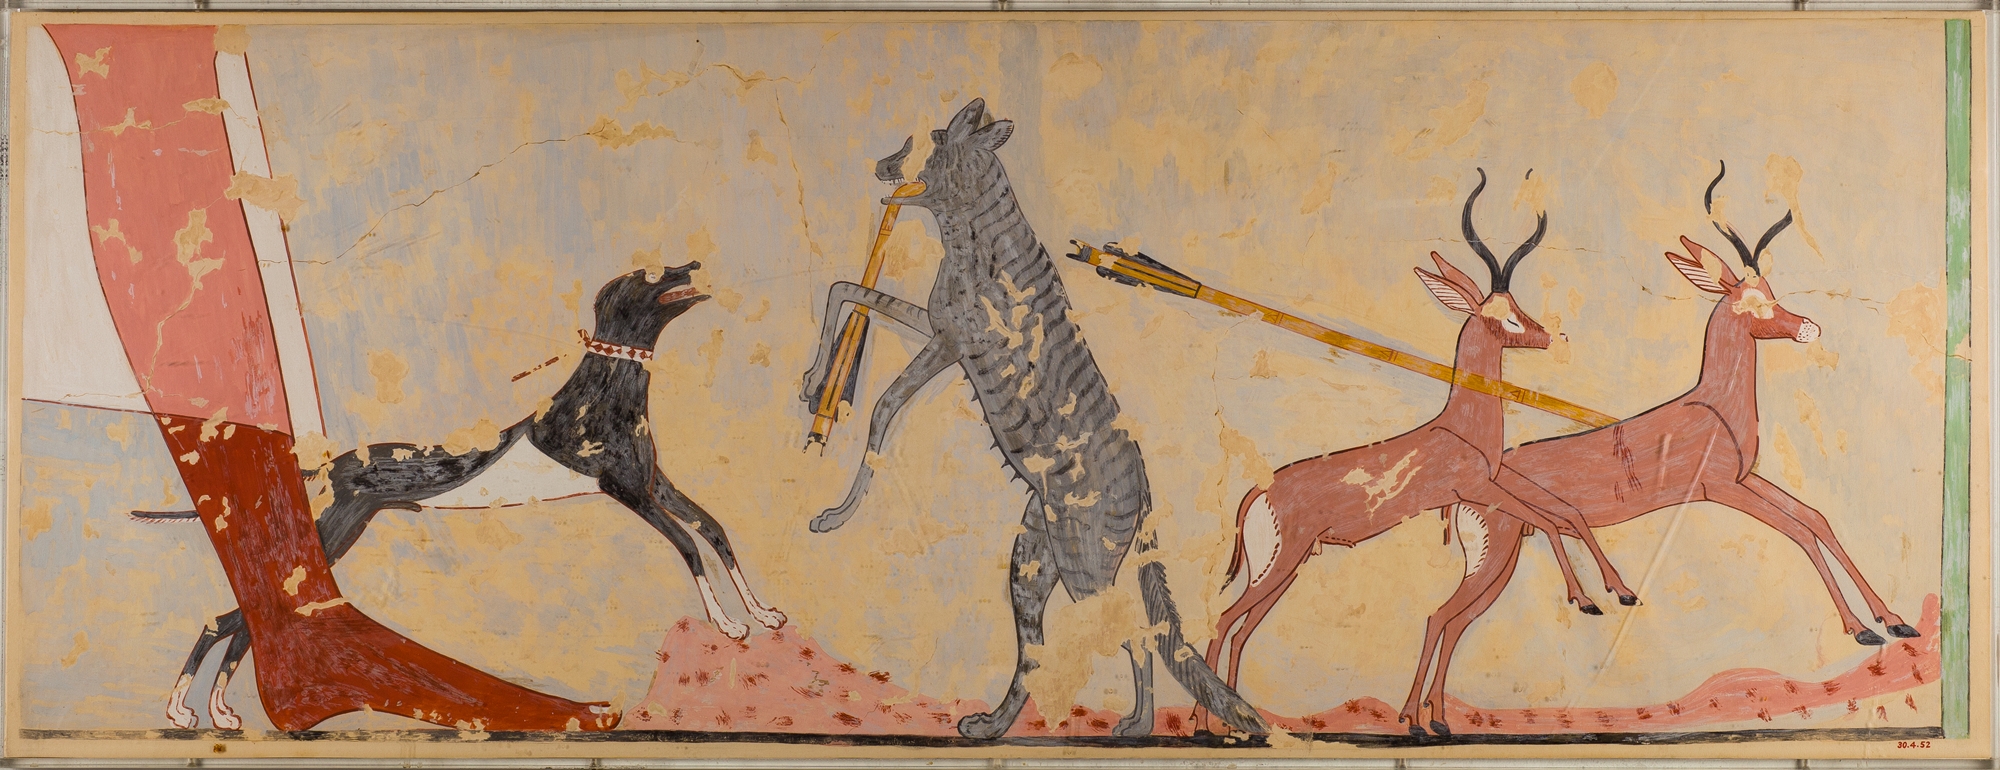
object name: facsimile, ineni tt 81, dog, wild dog hyena, gazelle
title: Hunting Scene, Tomb of Ineni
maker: nina de garis davies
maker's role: artist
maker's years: 1881-1965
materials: paper, paint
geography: egypt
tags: animals,hunting,dogs,love-poetry